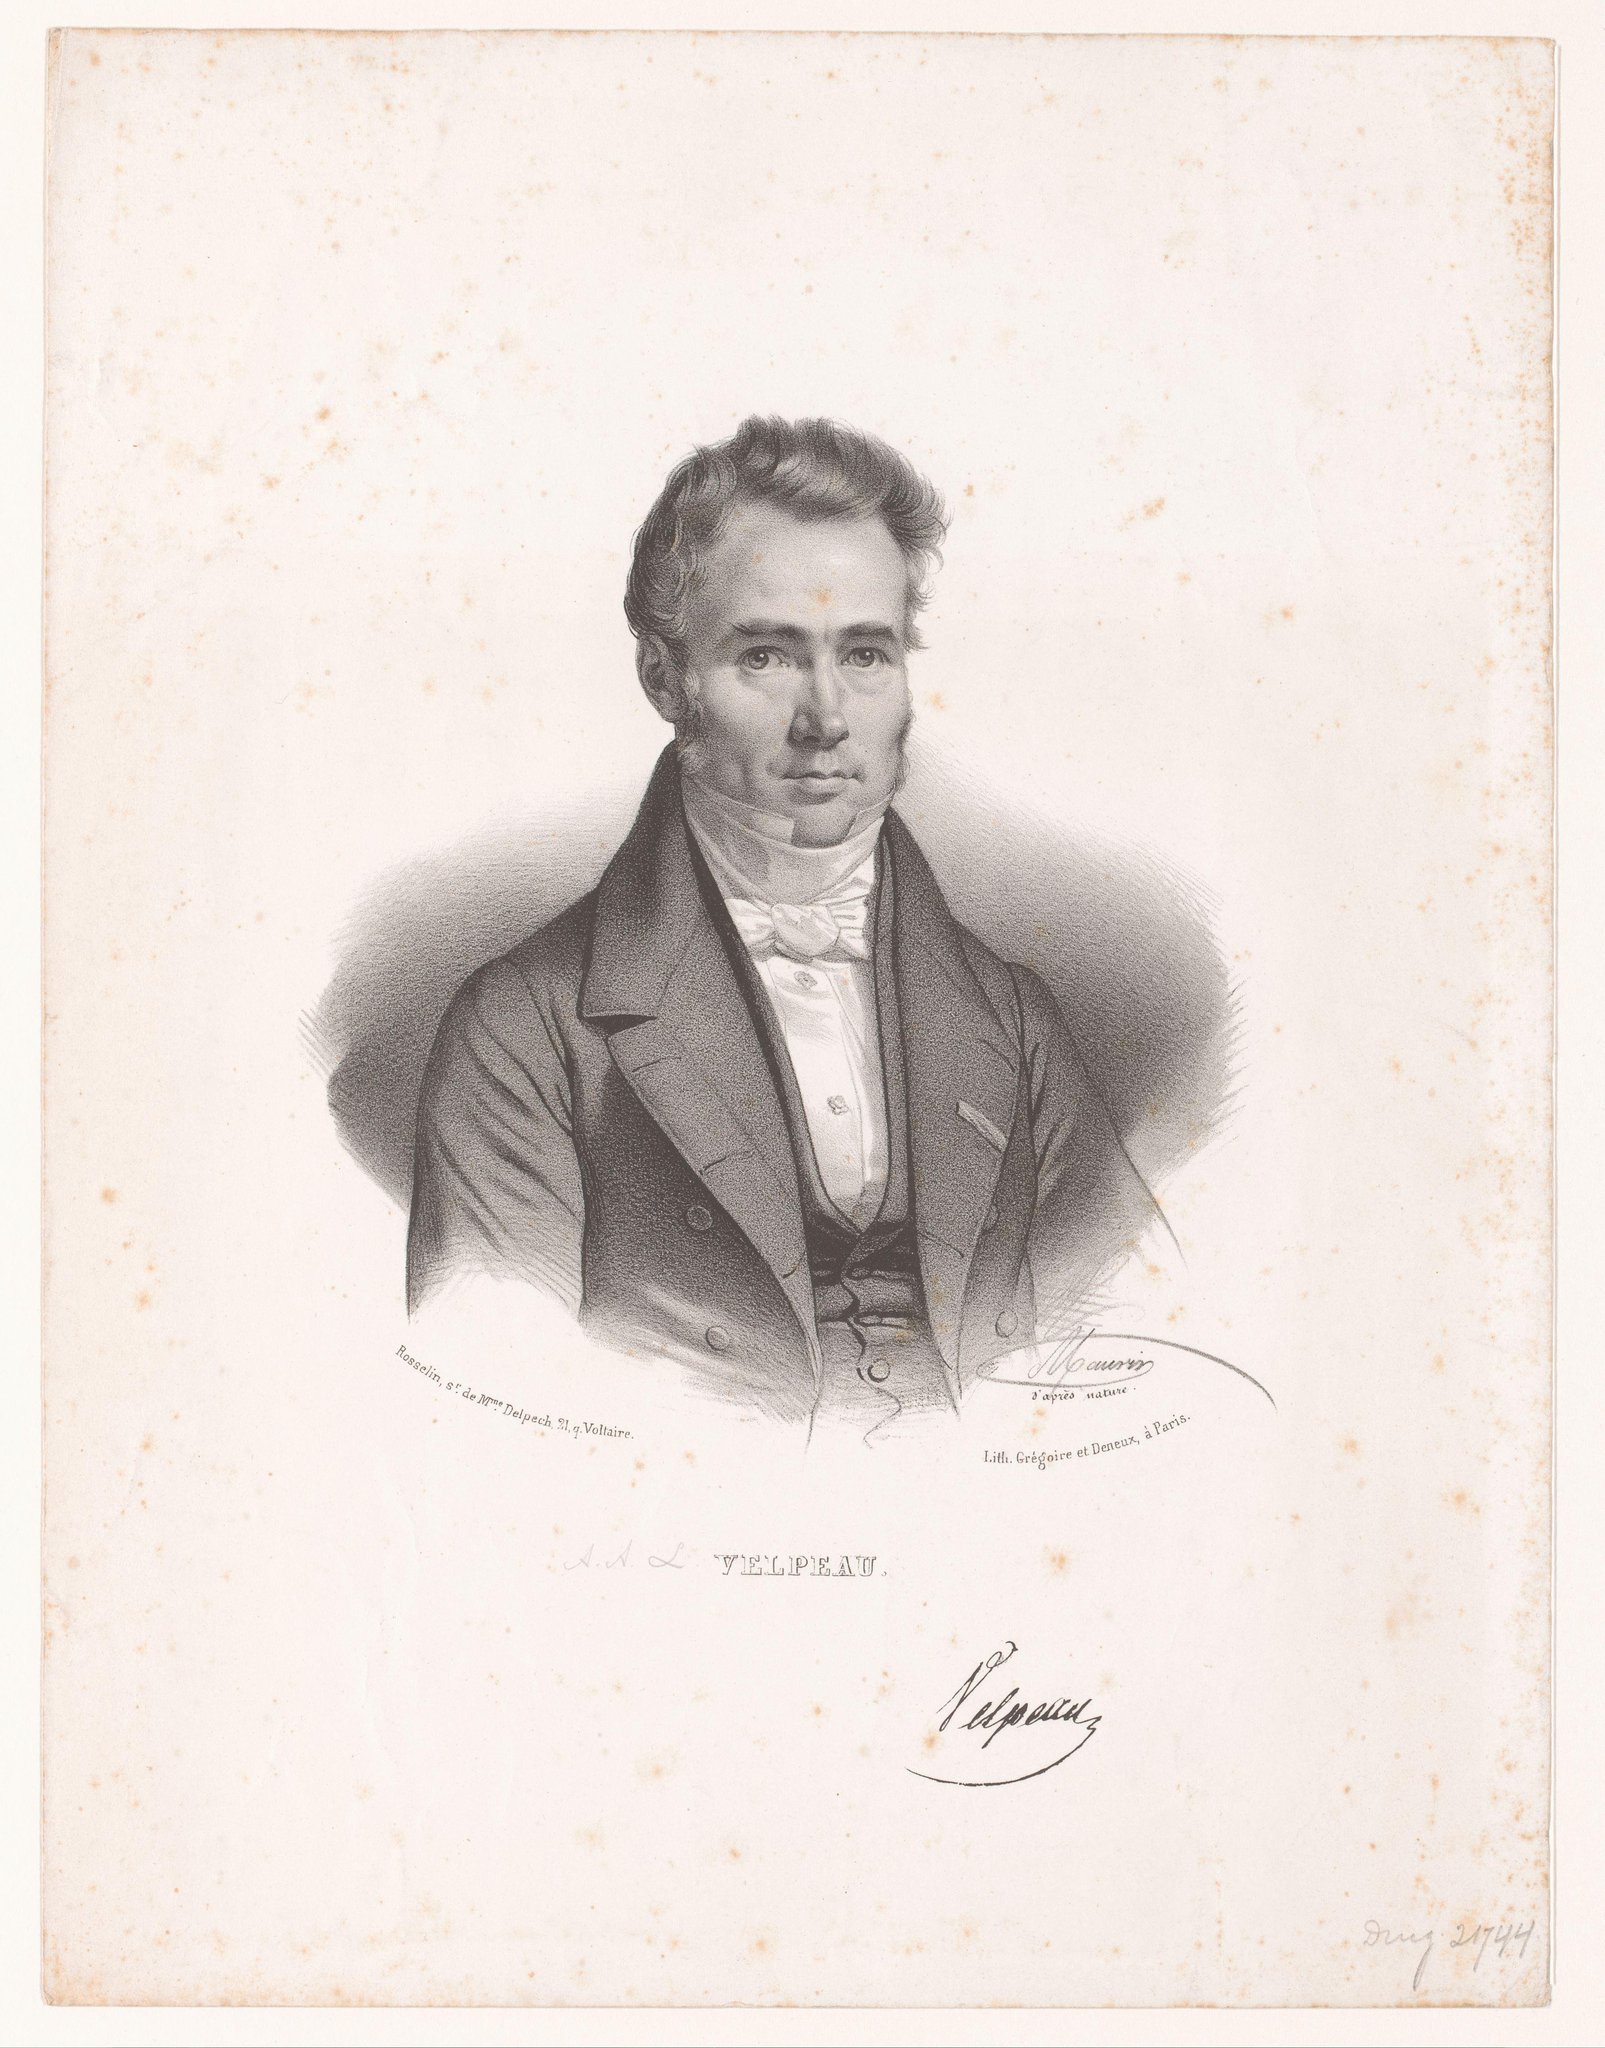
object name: print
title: Portret van Alfred-Armand-Louis-Marie Velpeau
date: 1835-1851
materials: paper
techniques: lithograph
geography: paris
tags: paris, historical persons, physician, doctor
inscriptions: collector's mark: Lugt 2228